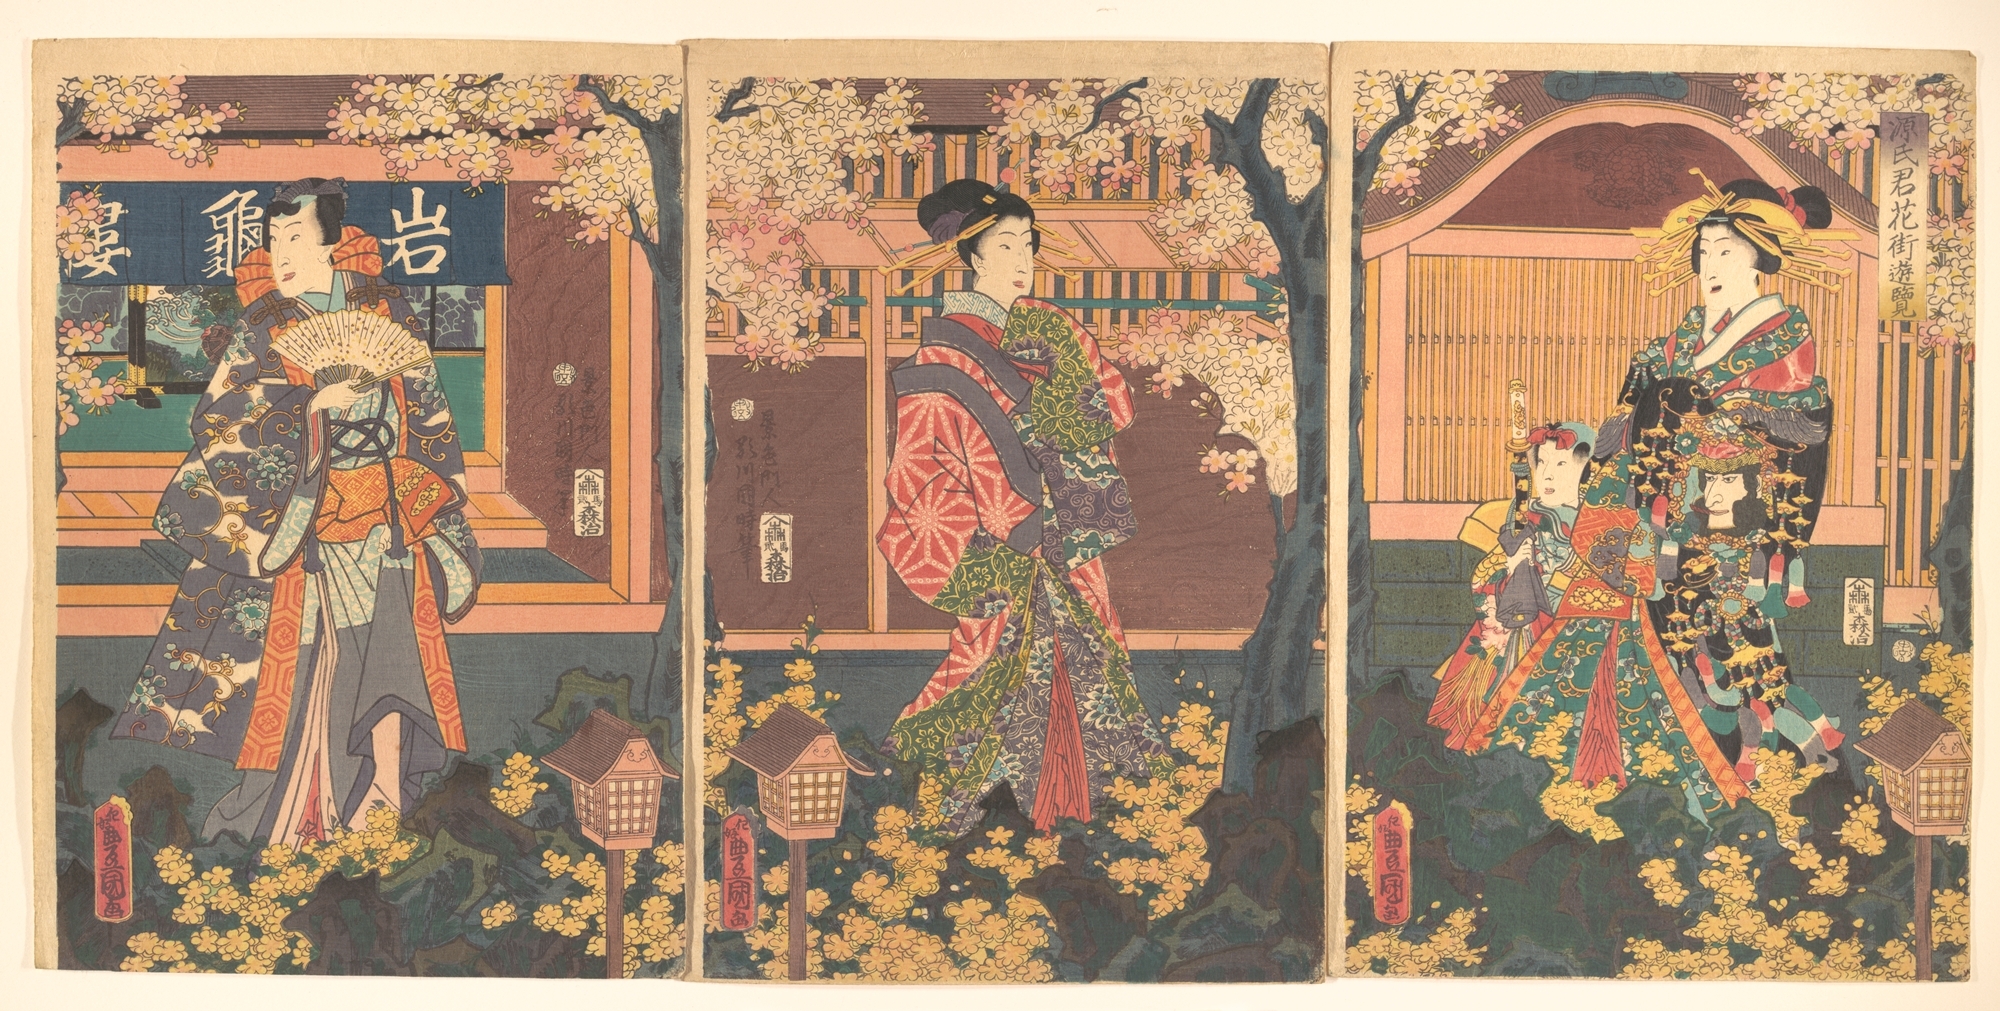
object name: print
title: Prince Genji Visits the Gankirō Tea House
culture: japanese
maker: utagawa kunisada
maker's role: artist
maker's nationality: japanese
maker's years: 1786-1864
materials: ink, paper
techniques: woodblock print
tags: children,women,trees